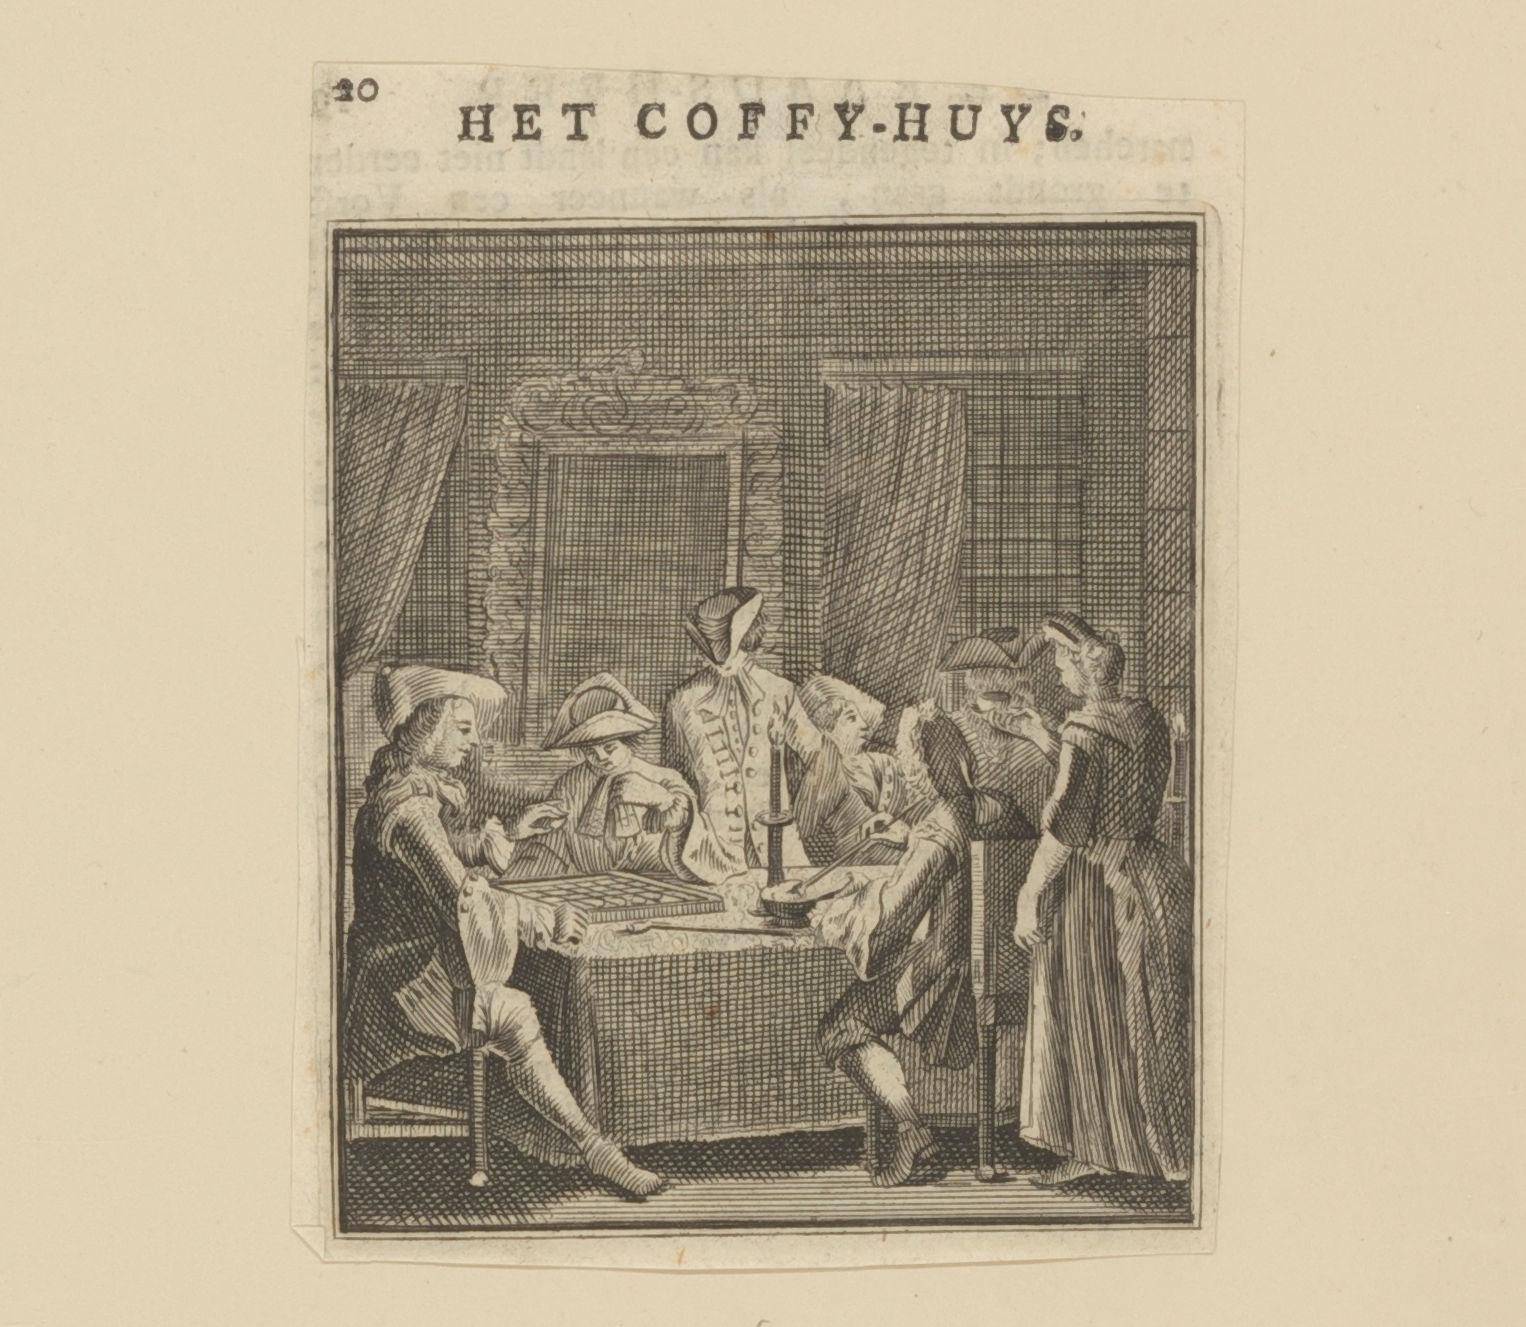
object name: print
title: Mannen aan een tafel spelen spellen in een koffiehuis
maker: Anonymous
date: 1719-1759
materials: paper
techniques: etching, letterpress printing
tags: board-games of chance, inn, coffee-house, public house, etc.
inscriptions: collector's mark: Lugt 1641, stamp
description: Prent met andere letterzetting gebruikt in: St. Clara, Abraham van. Iets voor allen. [Vertaald door] J. le Long. Amsterdam: Janssoons van Waesberge, 1719, dl. 2. En in: St. Clara, Abraham van. Iets voor allen. [Vertaald door] J. le Long. Amsterdam: Jan Roman de Jonge, 1741, dl. 2. En in: St. Clara, Abraham van. Iets voor allen. [Vertaald door] J. le Long. Amsterdam: Jan Roman, 1759, dl. 2. Huidige prent uit een andere editie. Naar een prent van: Jan Luyken.